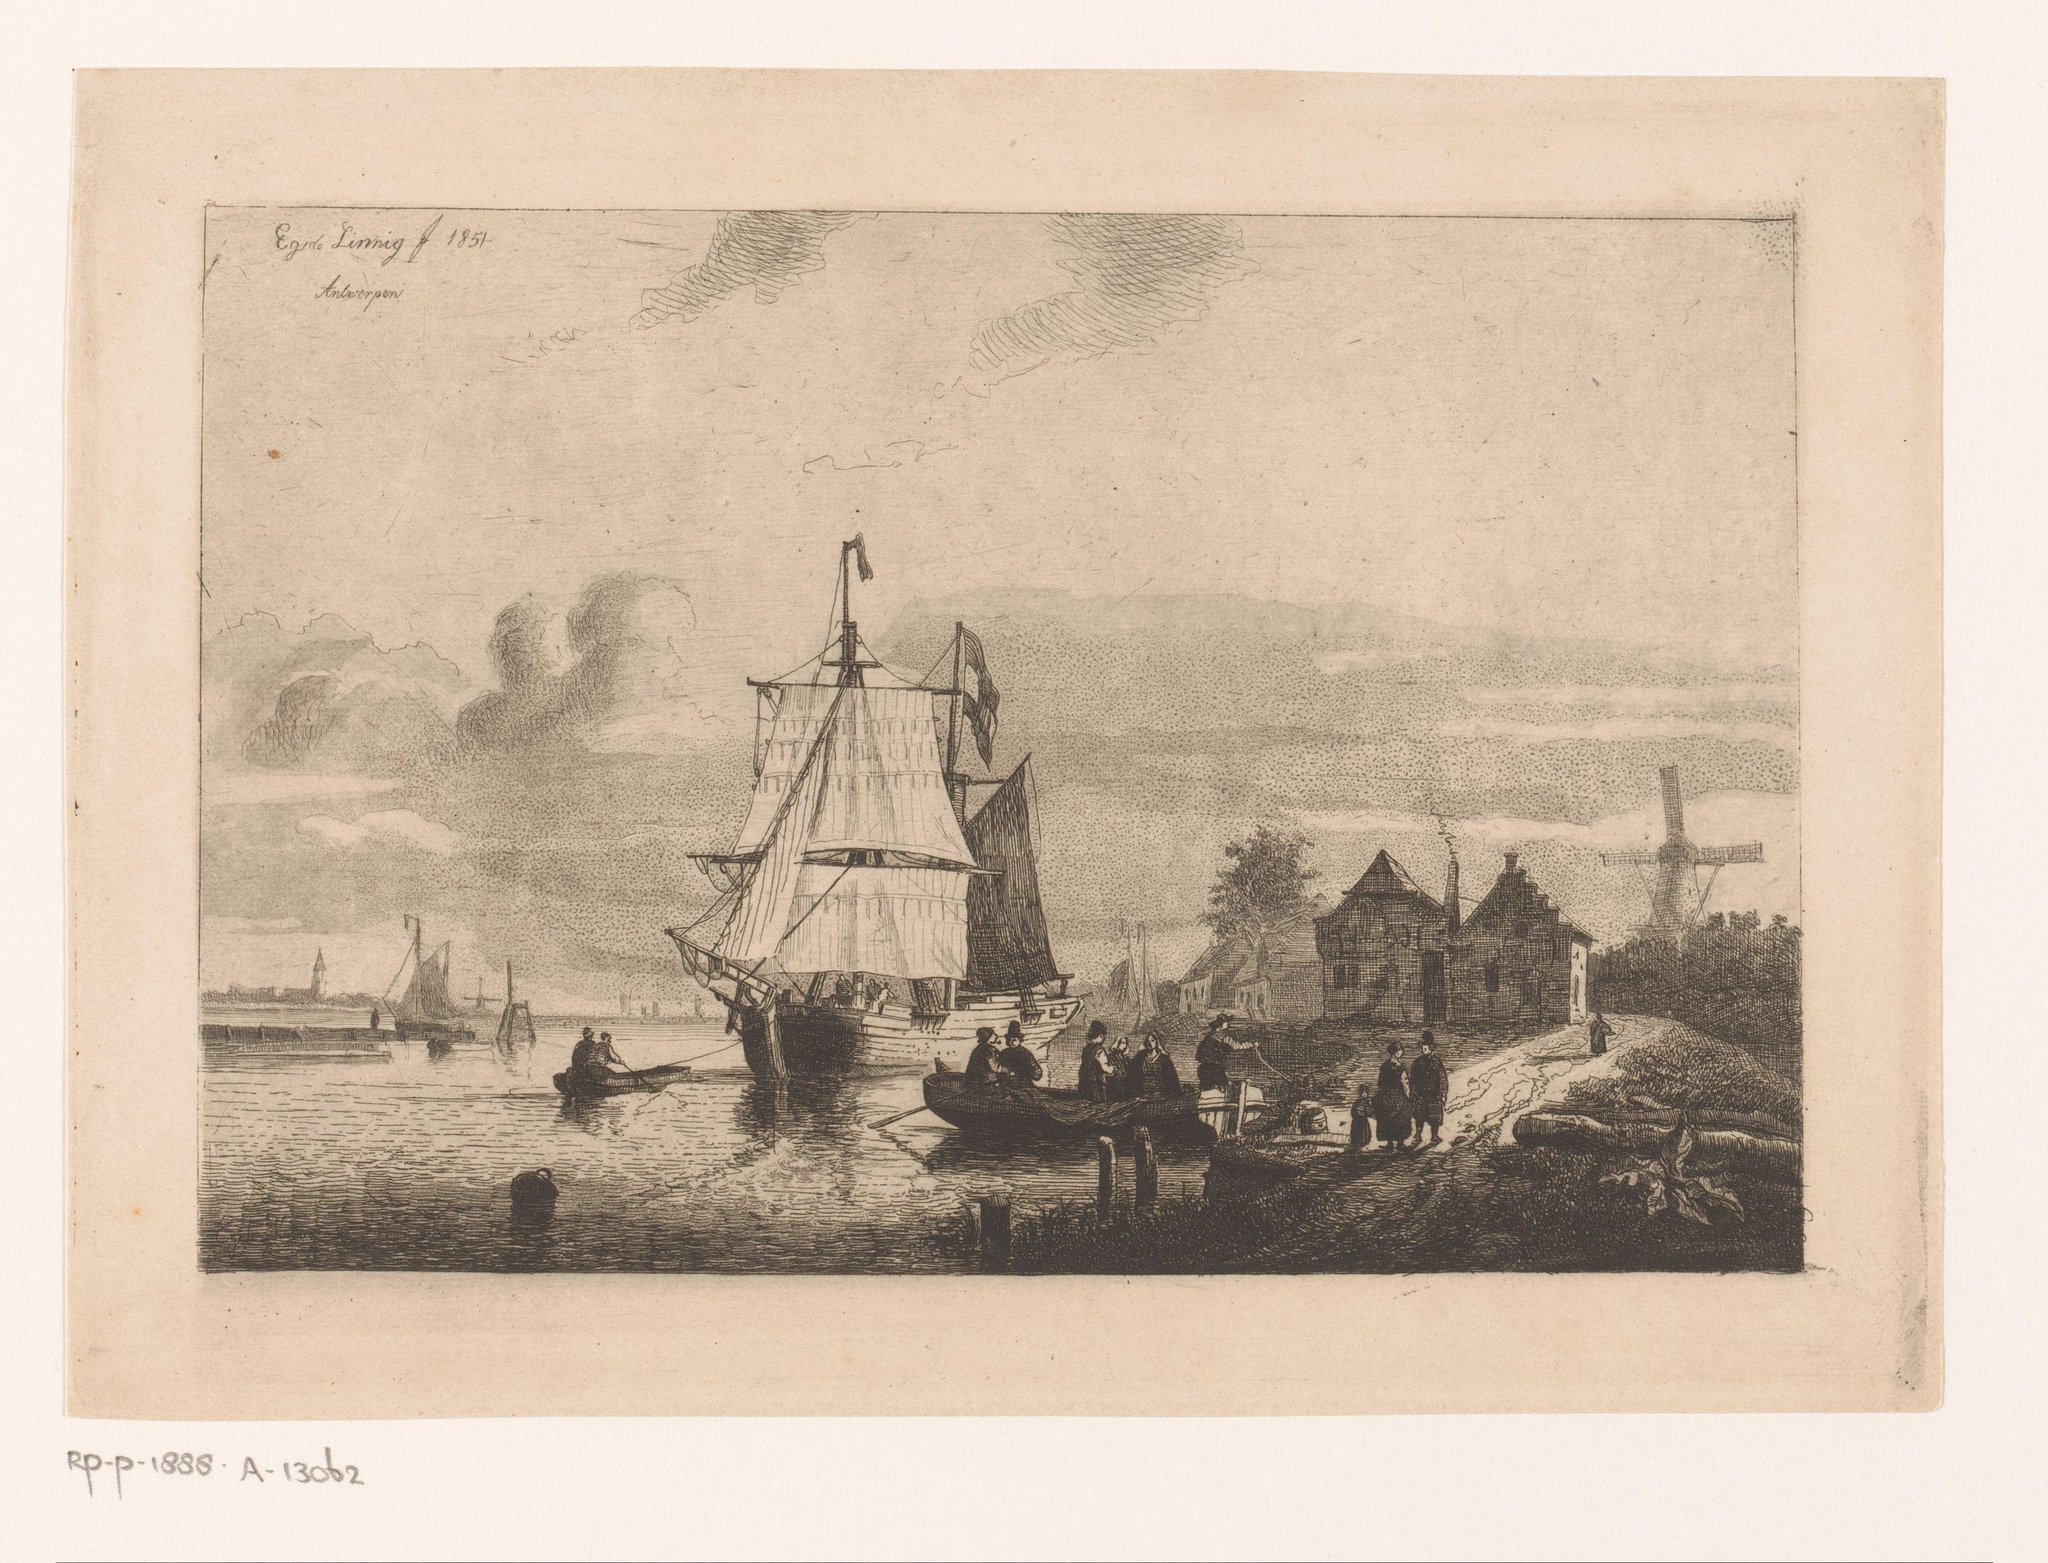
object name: print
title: Gezicht op Tholen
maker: egidius linnig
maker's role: draughtsman, print maker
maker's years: 1821-1860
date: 1851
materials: paper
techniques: aquatint, etching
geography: antwerp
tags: prospect of village, silhouette of village, sailing-ship, sailing-boat, windmill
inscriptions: collector's mark: Lugt 2228